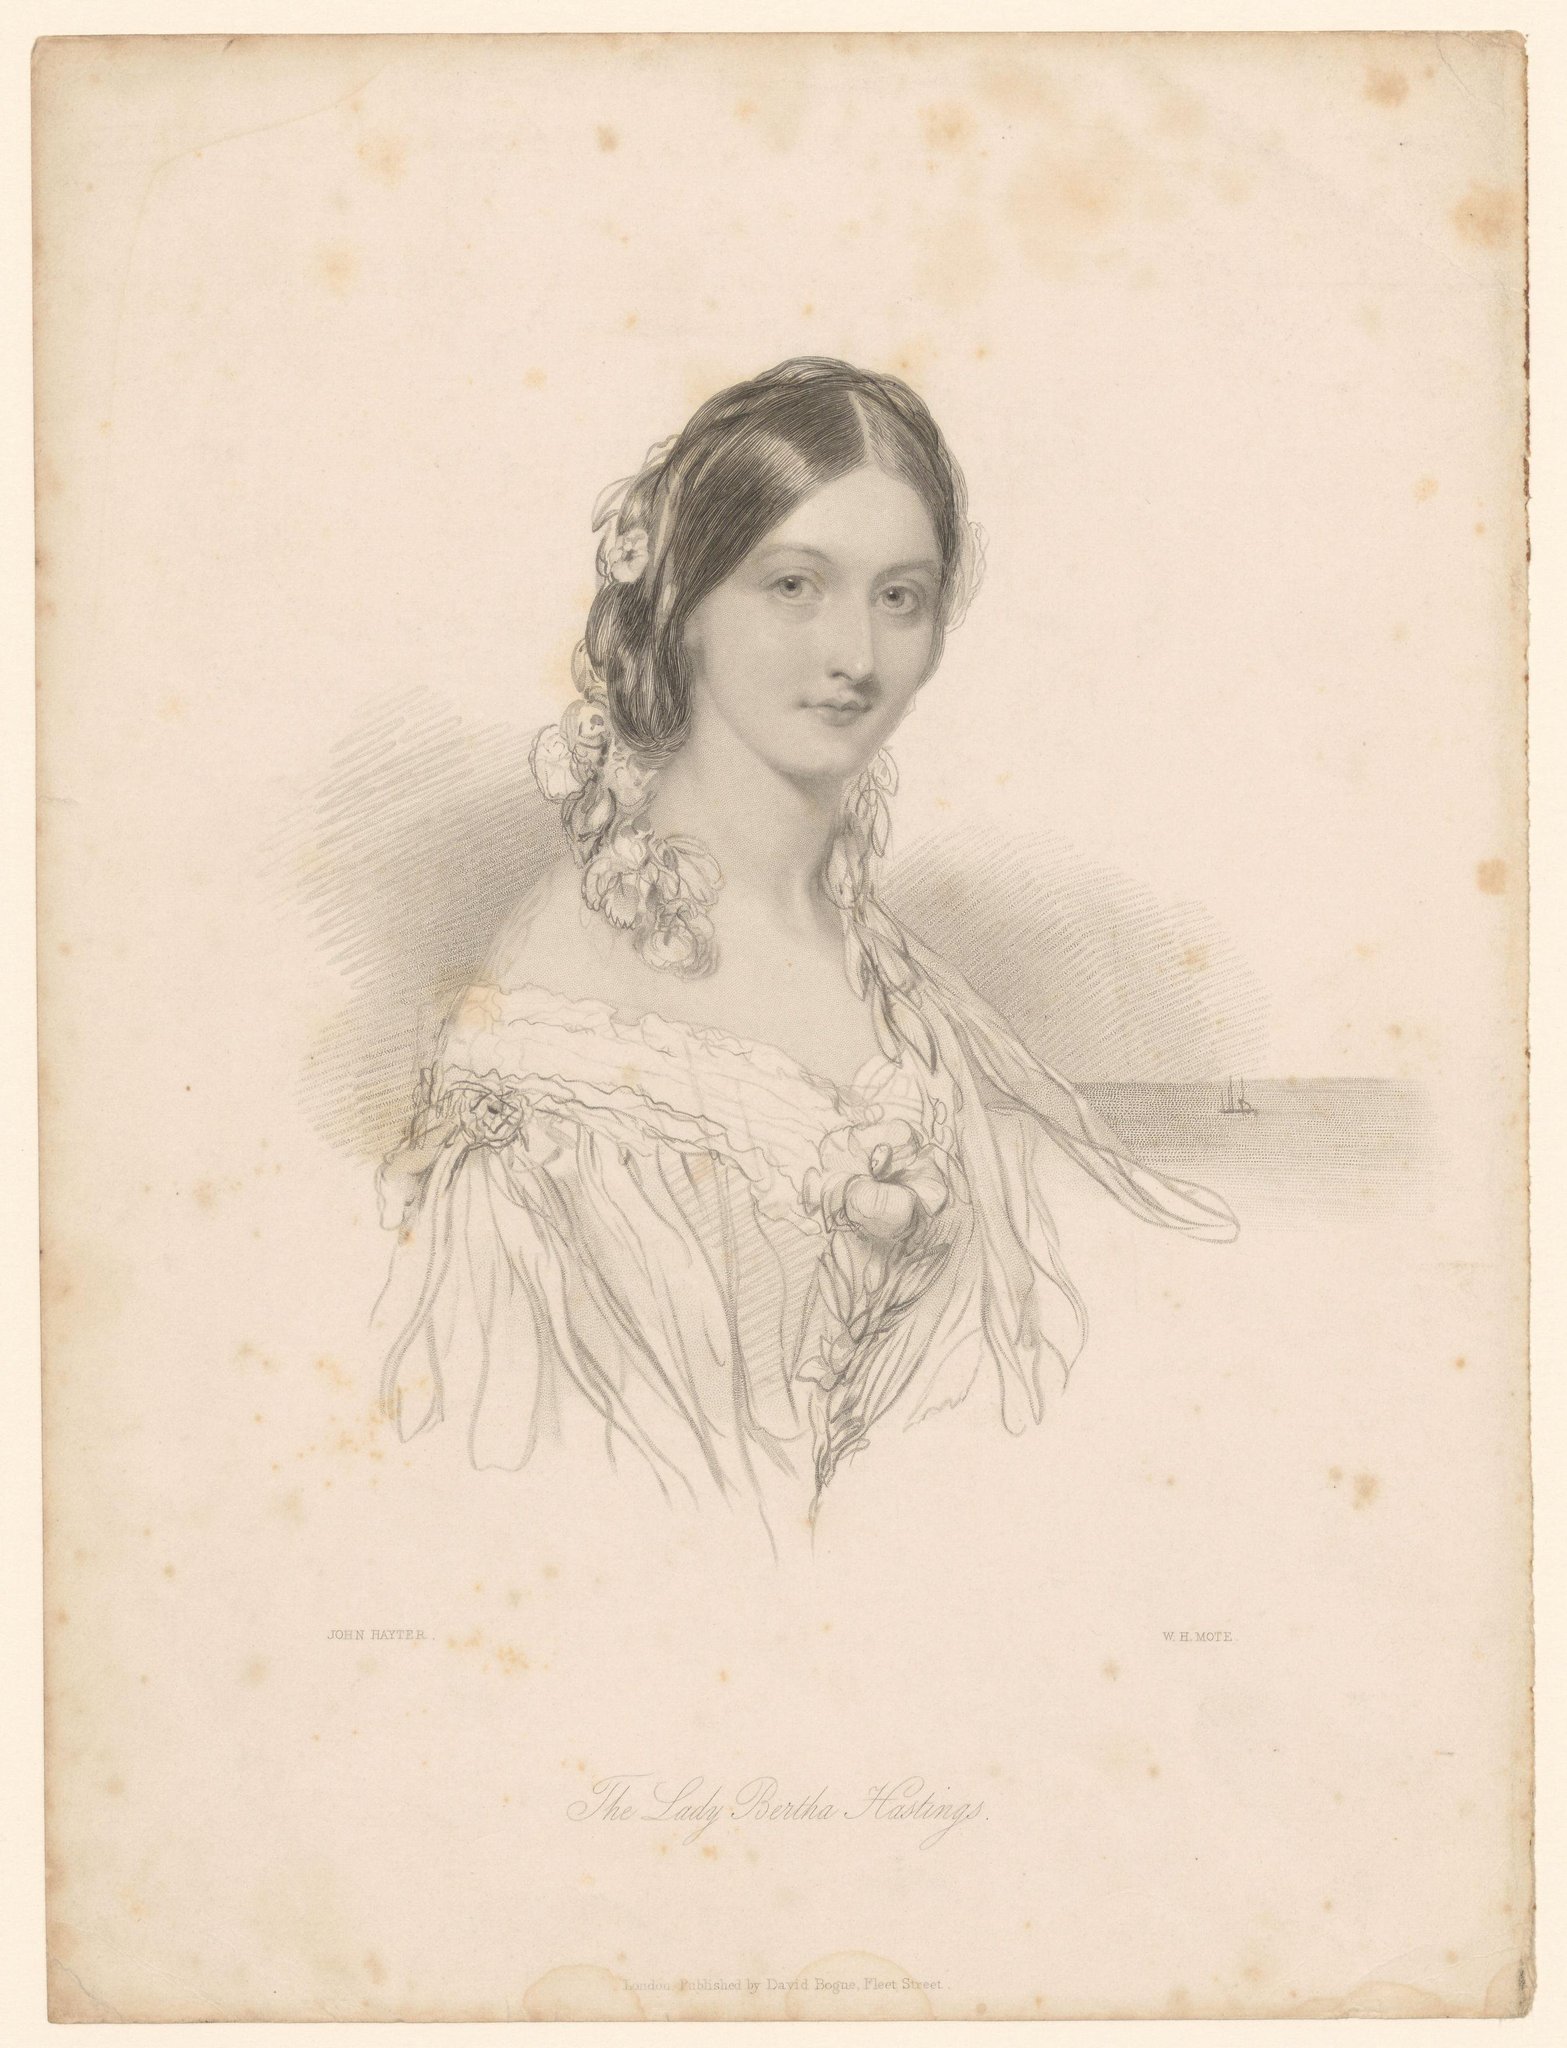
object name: print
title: Portret van Bertha Clifton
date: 1852-1856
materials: paper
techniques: etching, roulette, engraving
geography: london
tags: historical persons - bb - woman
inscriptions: collector's mark: Lugt 2228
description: Prent uit: The Court Album: A Series of Portraits of the Female Aristocracy. Londen: David Bogue, [ca. 1852-1856].